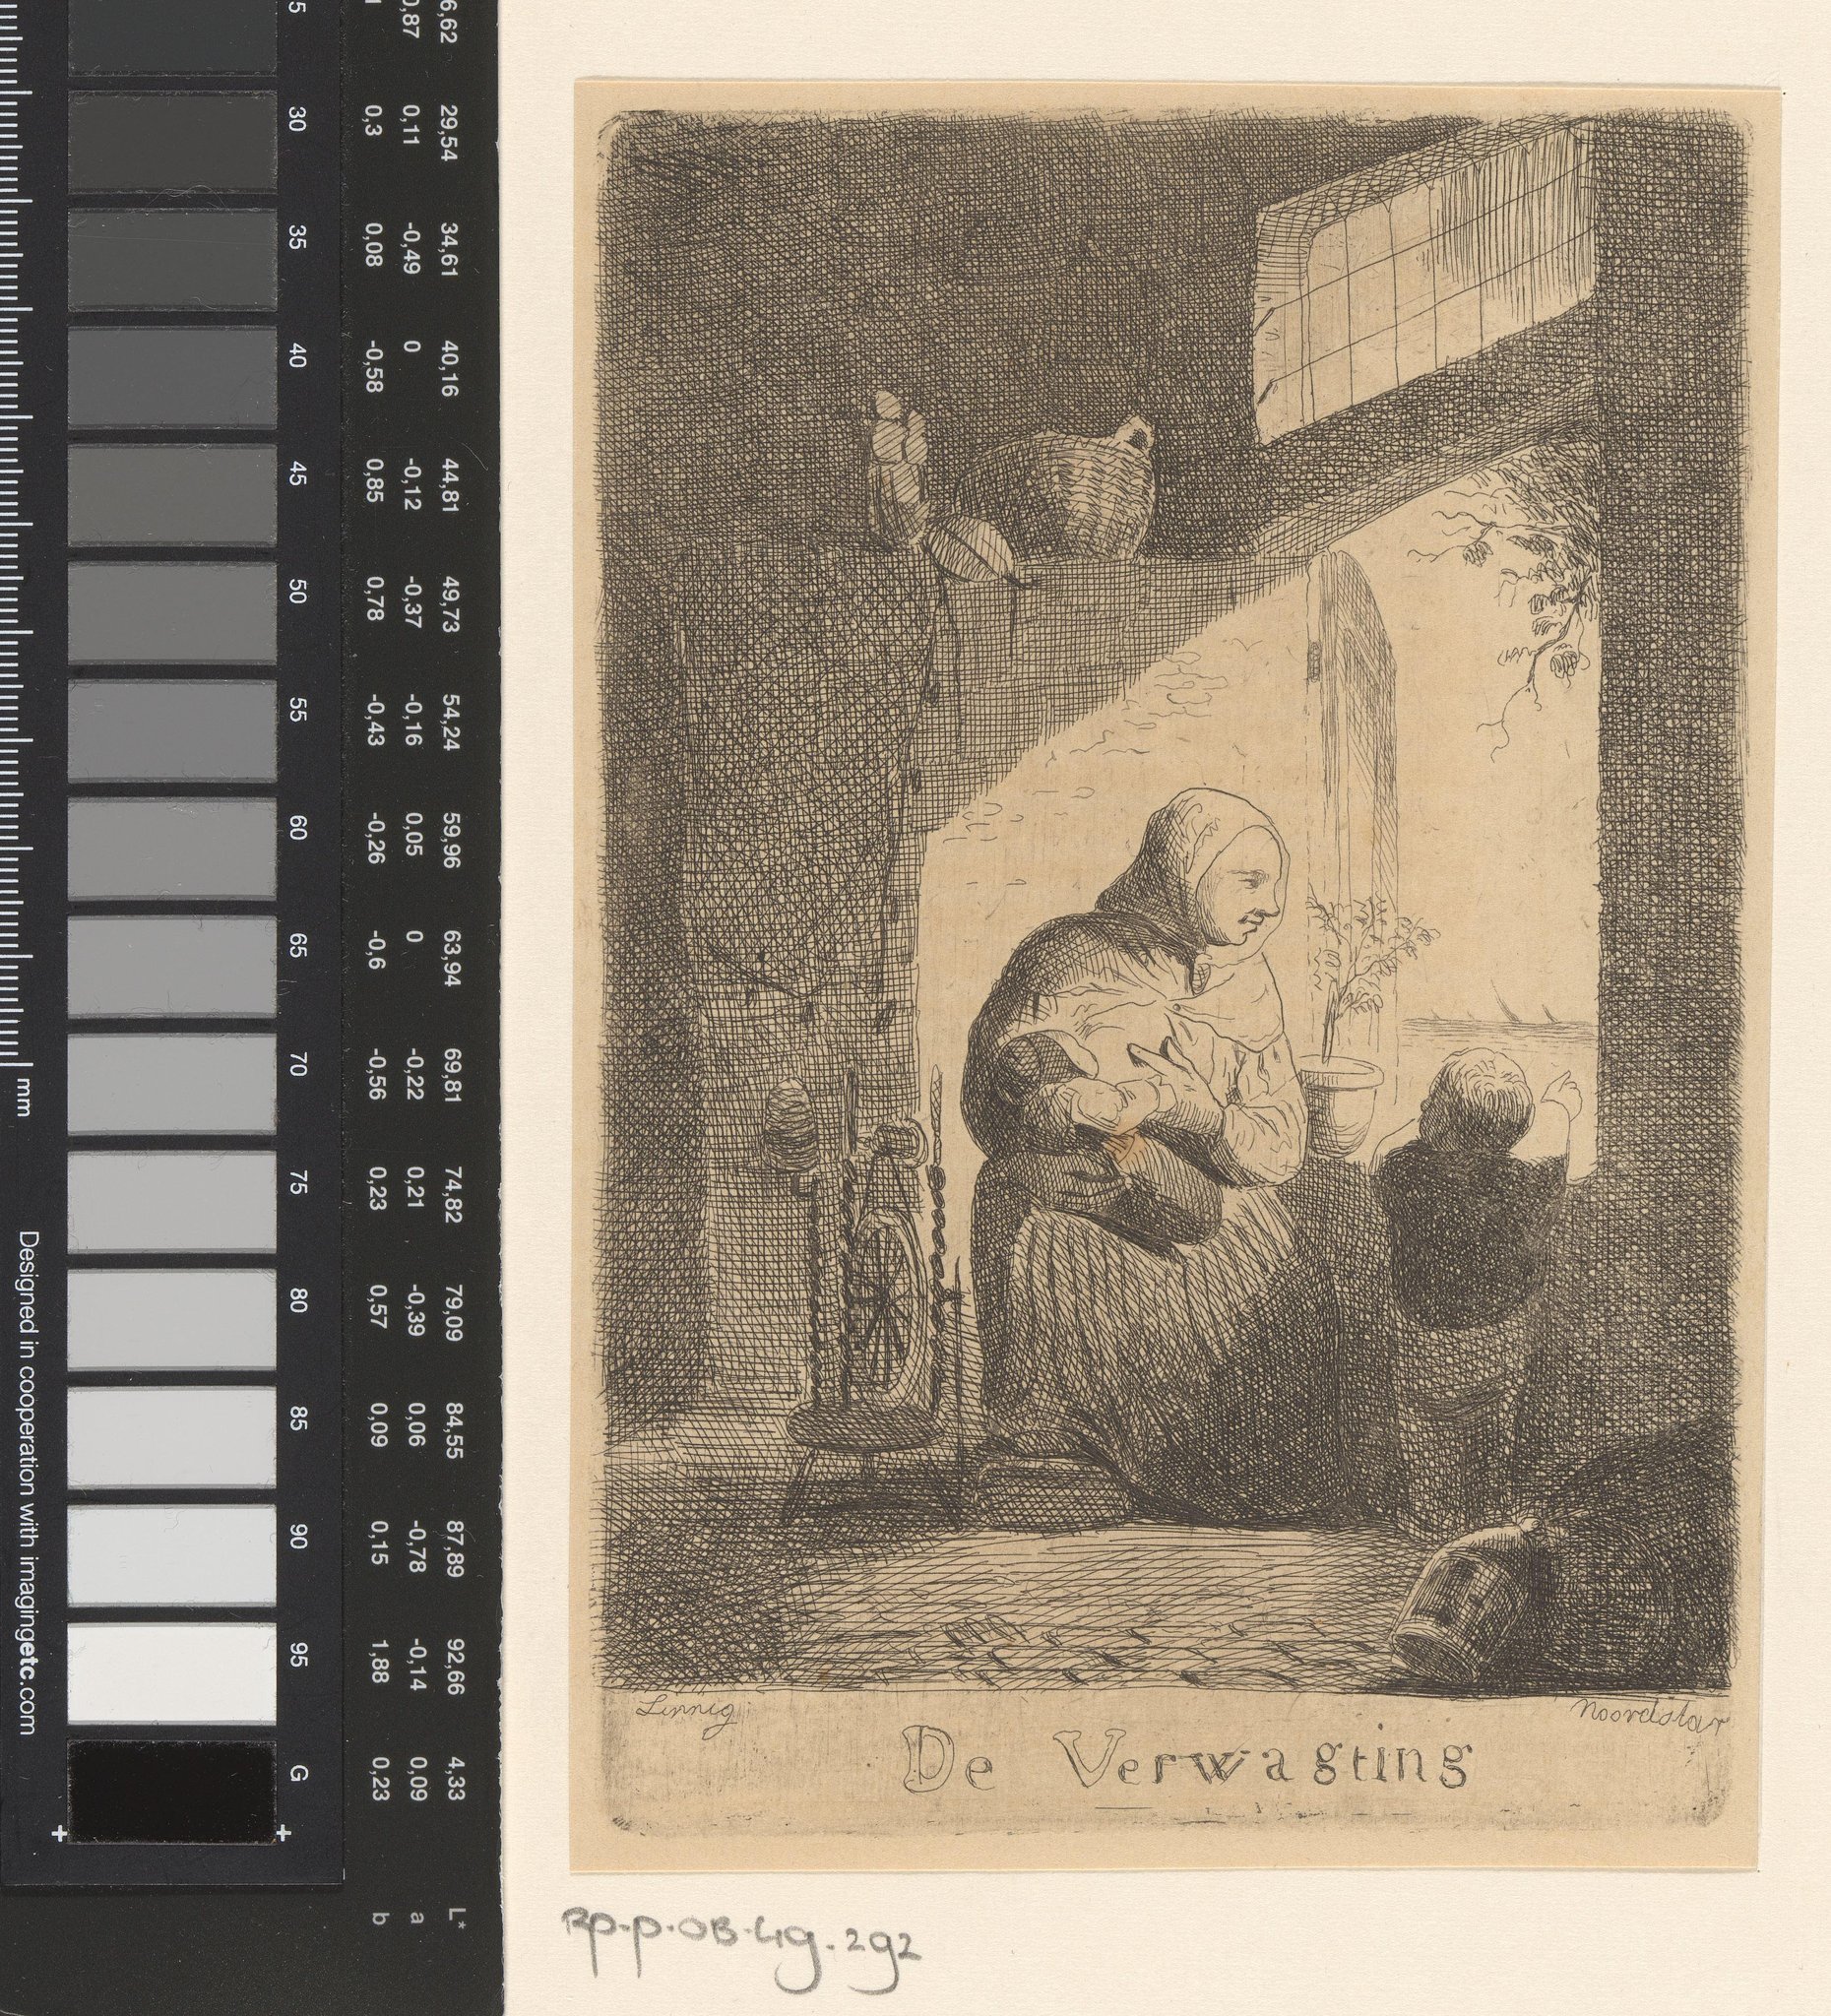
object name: print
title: De Verwagting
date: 1842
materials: paper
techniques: etching, intaglio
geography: antwerp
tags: feeding a baby, one lover waiting for the other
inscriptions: collector's mark: Lugt 2228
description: Prent uit: De Noordstar: tijdschrift voor letteren, kunsten en wetenschappen, 3 (1842).